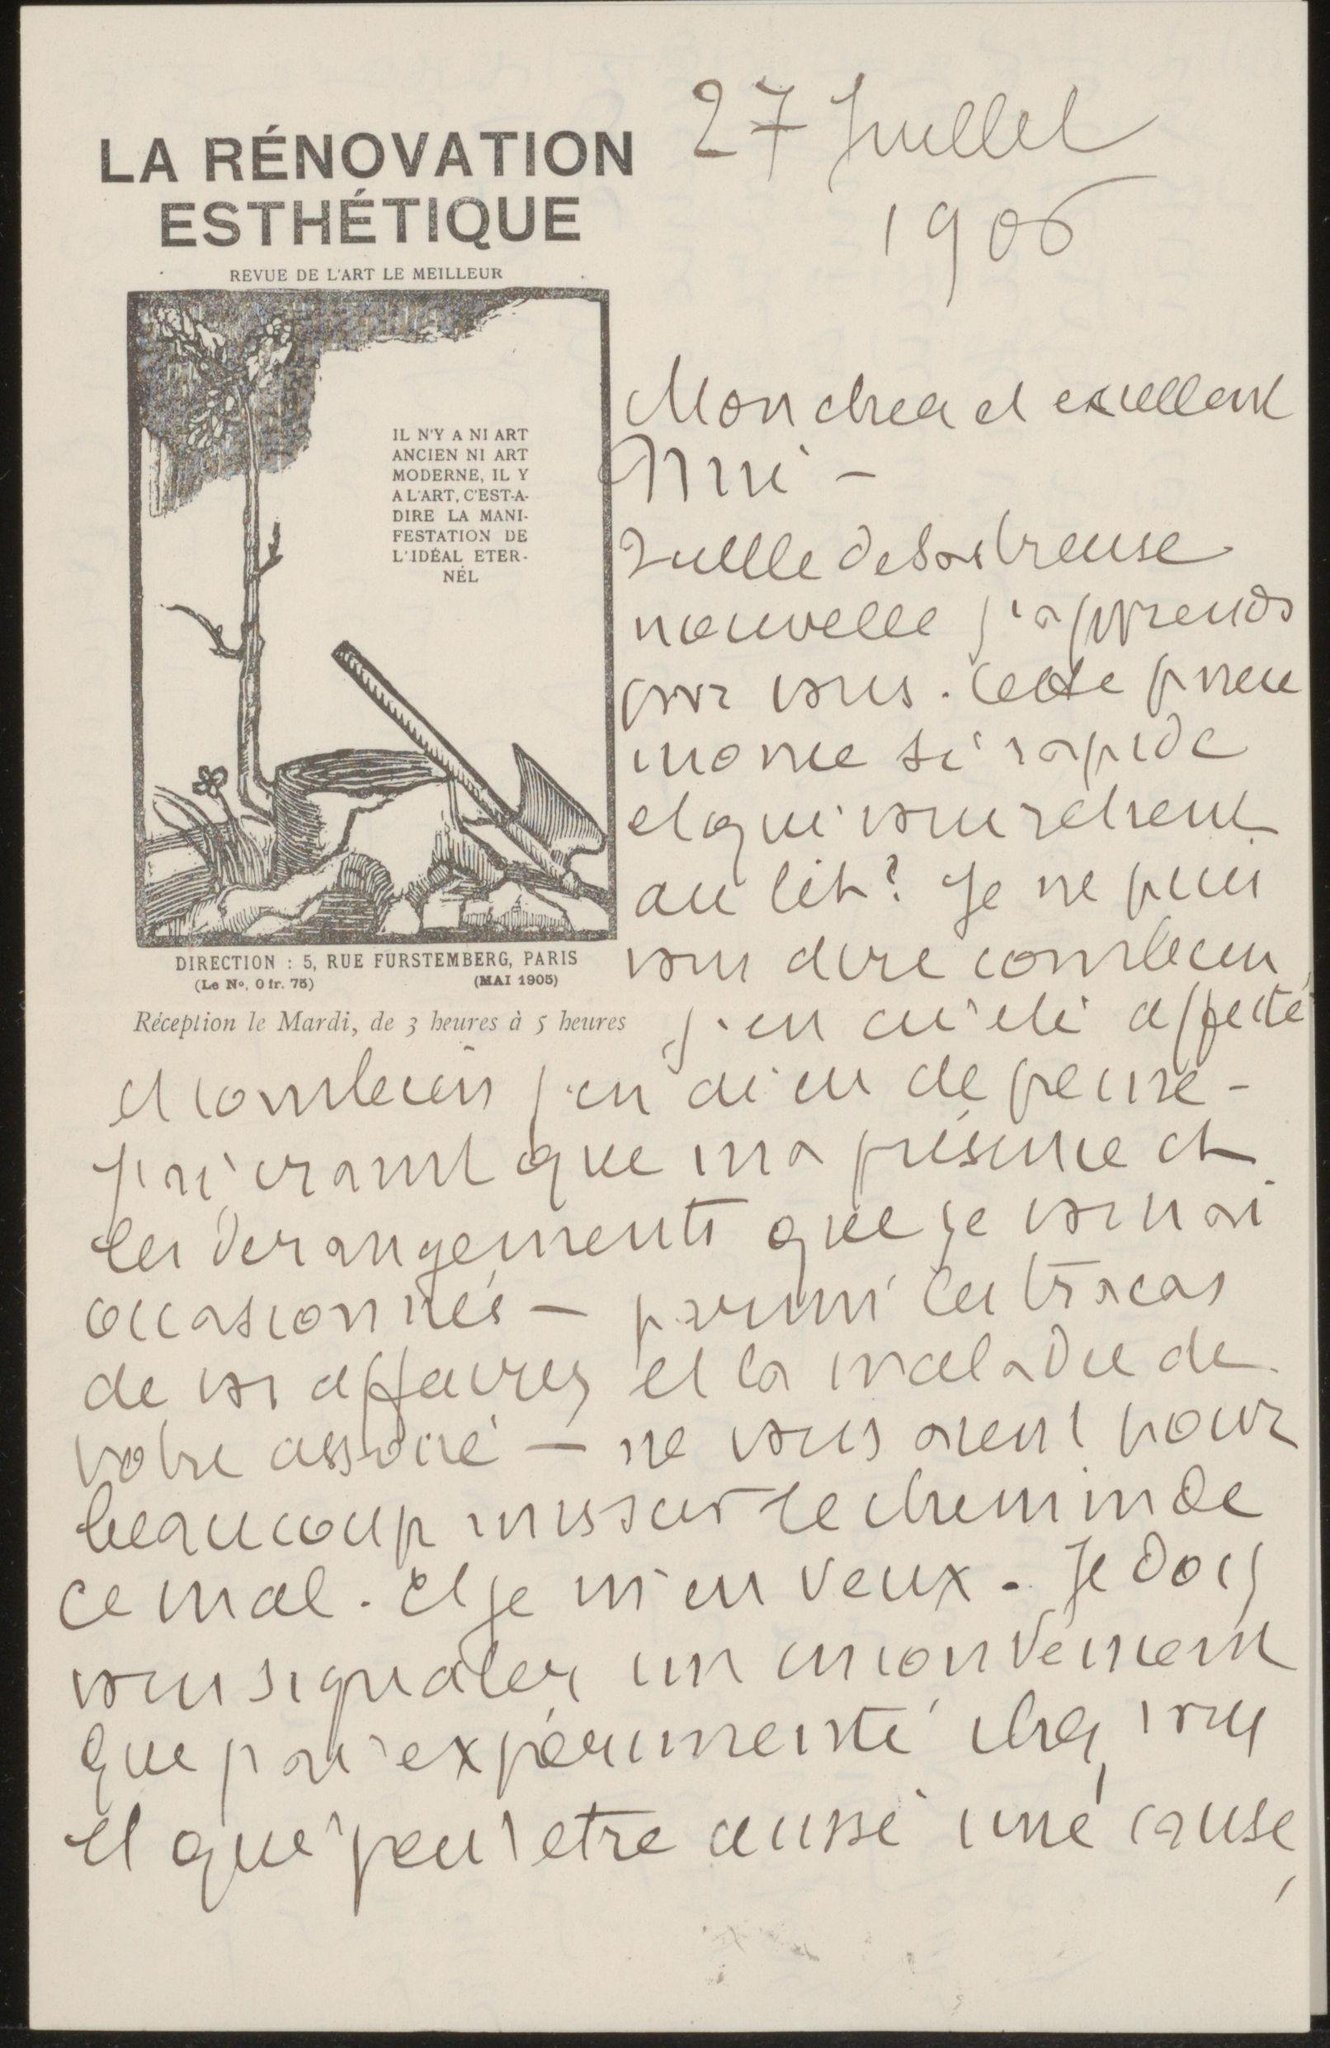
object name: letter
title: Brief aan Andries Bonger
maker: émile bernard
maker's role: print maker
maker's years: 1868-1941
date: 1906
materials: ink, paper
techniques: pen, printing, writing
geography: tonnerre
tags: rome, painter, rafaël, paris, charles baudelaire, sculptor, michelangelo, titiaan, amsterdam, andries bonger, artist, leonardo da vinci, stéphane mallarmé, edgar allan poe, applied arts, arts and crafts; industrial design, literature ~ arts, painting (including book-illumination, miniature-painting), diseases